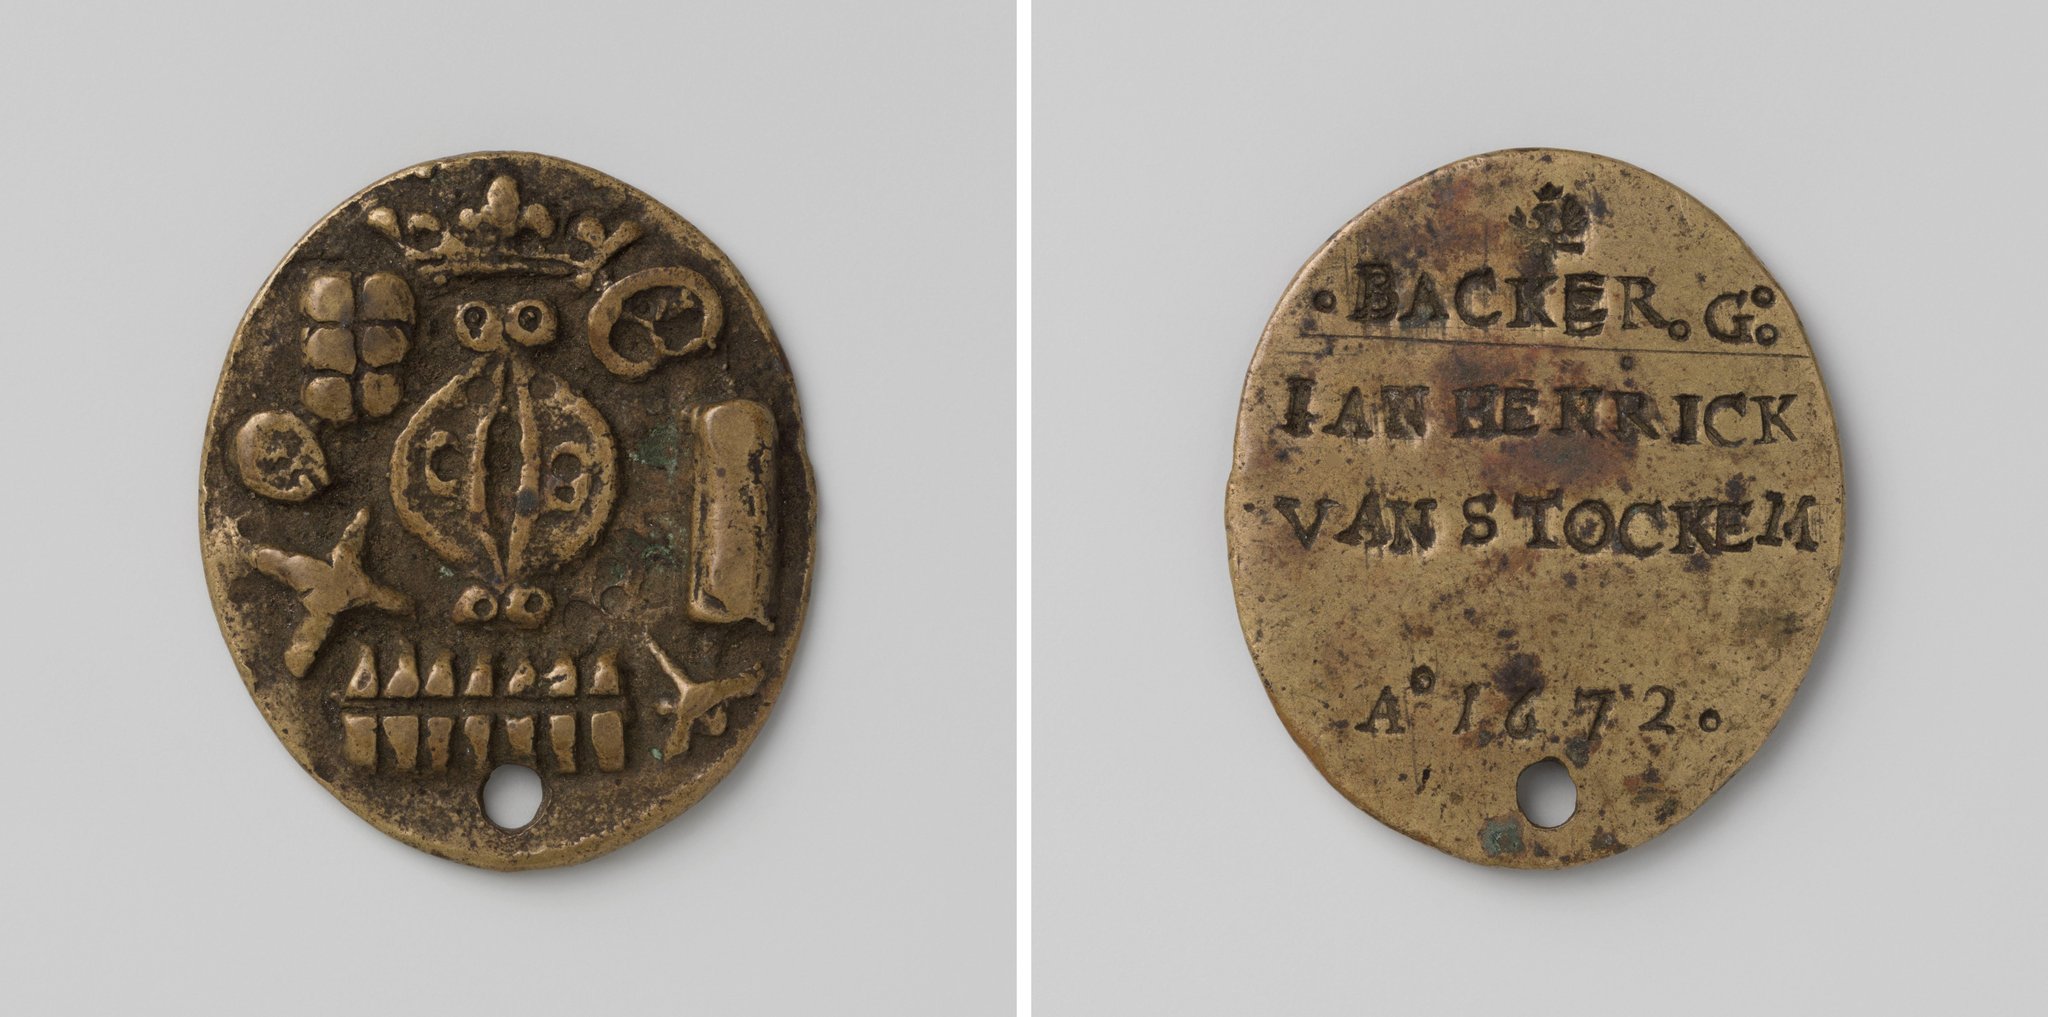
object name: medal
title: Bakkersgilde van Deventer, gildepenning van Jan Henrick van Stockem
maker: Anonymous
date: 1672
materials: brass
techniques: casting, engraving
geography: deventer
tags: deventer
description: Messing ovale penning met gat aan onderzijde. Voorzijde: ronde koek, waarop krakelingen liggen onder een kroon; daaromheen verschillende soorten brood, koek en gebak. Keerzijde: opschrift